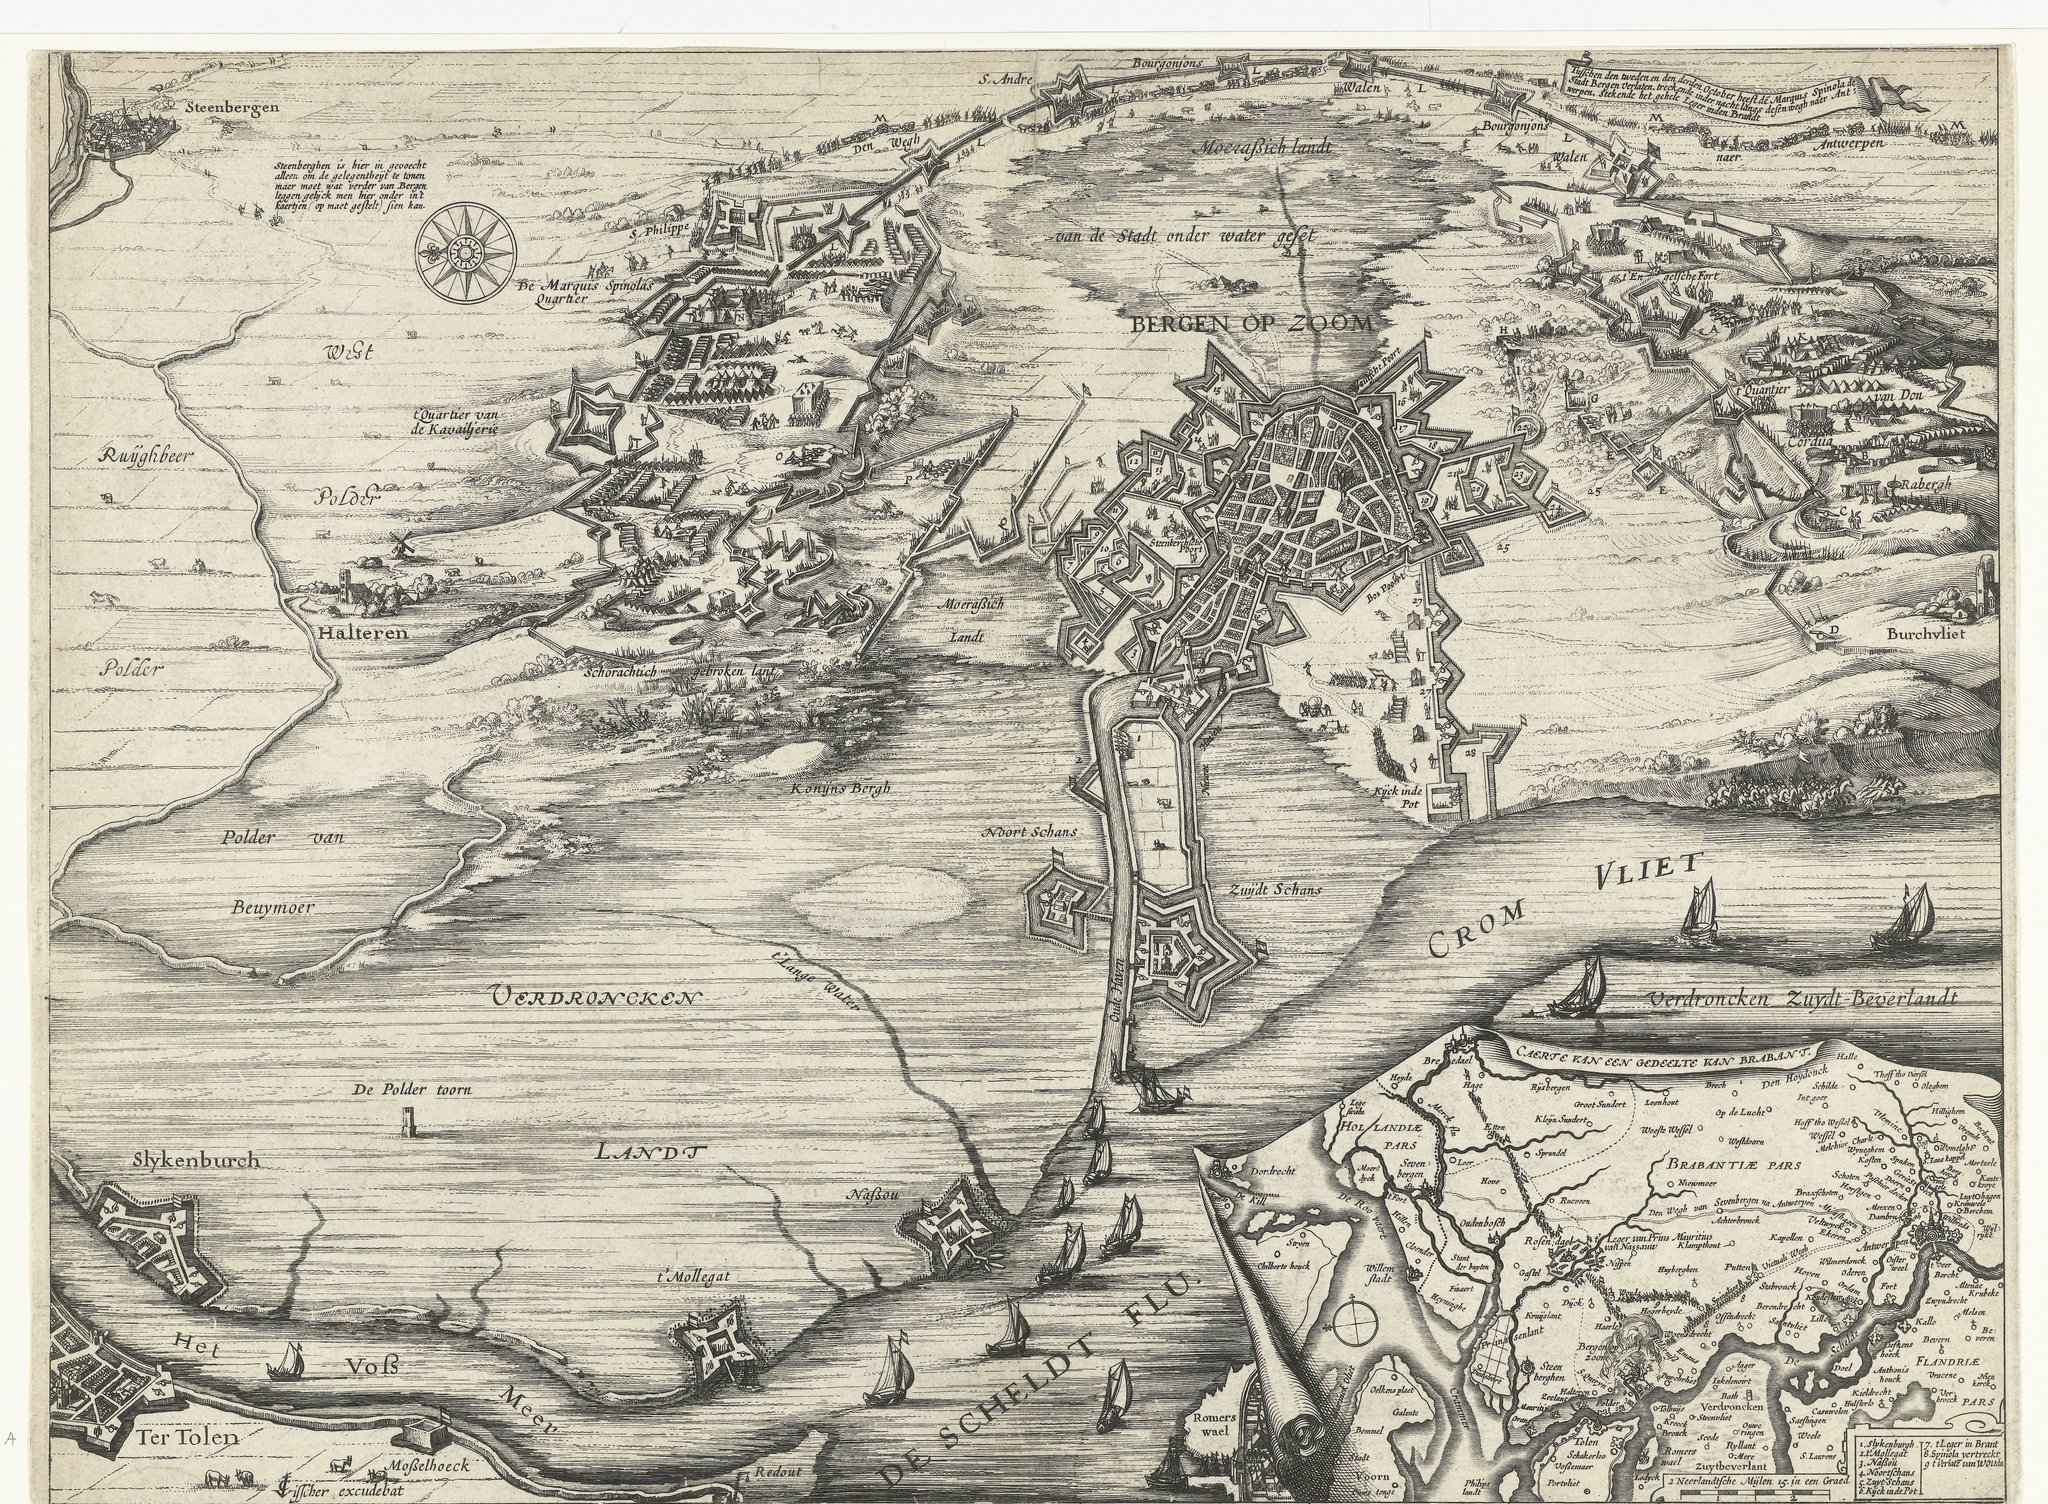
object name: print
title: Beleg van Bergen op Zoom, 1622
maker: claes jansz. visscher (ii)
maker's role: draughtsman, print maker, publisher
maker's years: 1586-1652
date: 1622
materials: paper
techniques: etching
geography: amsterdam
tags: siege, position war, bergen op zoom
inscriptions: collector's mark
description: Kaart van het mislukte beleg van Bergen op Zoom door het Spaanse leger onder Spinola en Velasco, 18 juli - 3 oktober 1622. Plan van de stad en omgeving met waterwegen en omsingeling door de Spaanse troepen. Rechtsonder een kaart van het groter gebied in Brabant met opkrullende randen. Rechtsbovenaan een kleine banderol met 3 regels tekst met de vermelding dat Spinola het beleg heeft gestaakt tussen 2 en 3 oktober. Bij de voorstelling behoren twee tekstbladen.